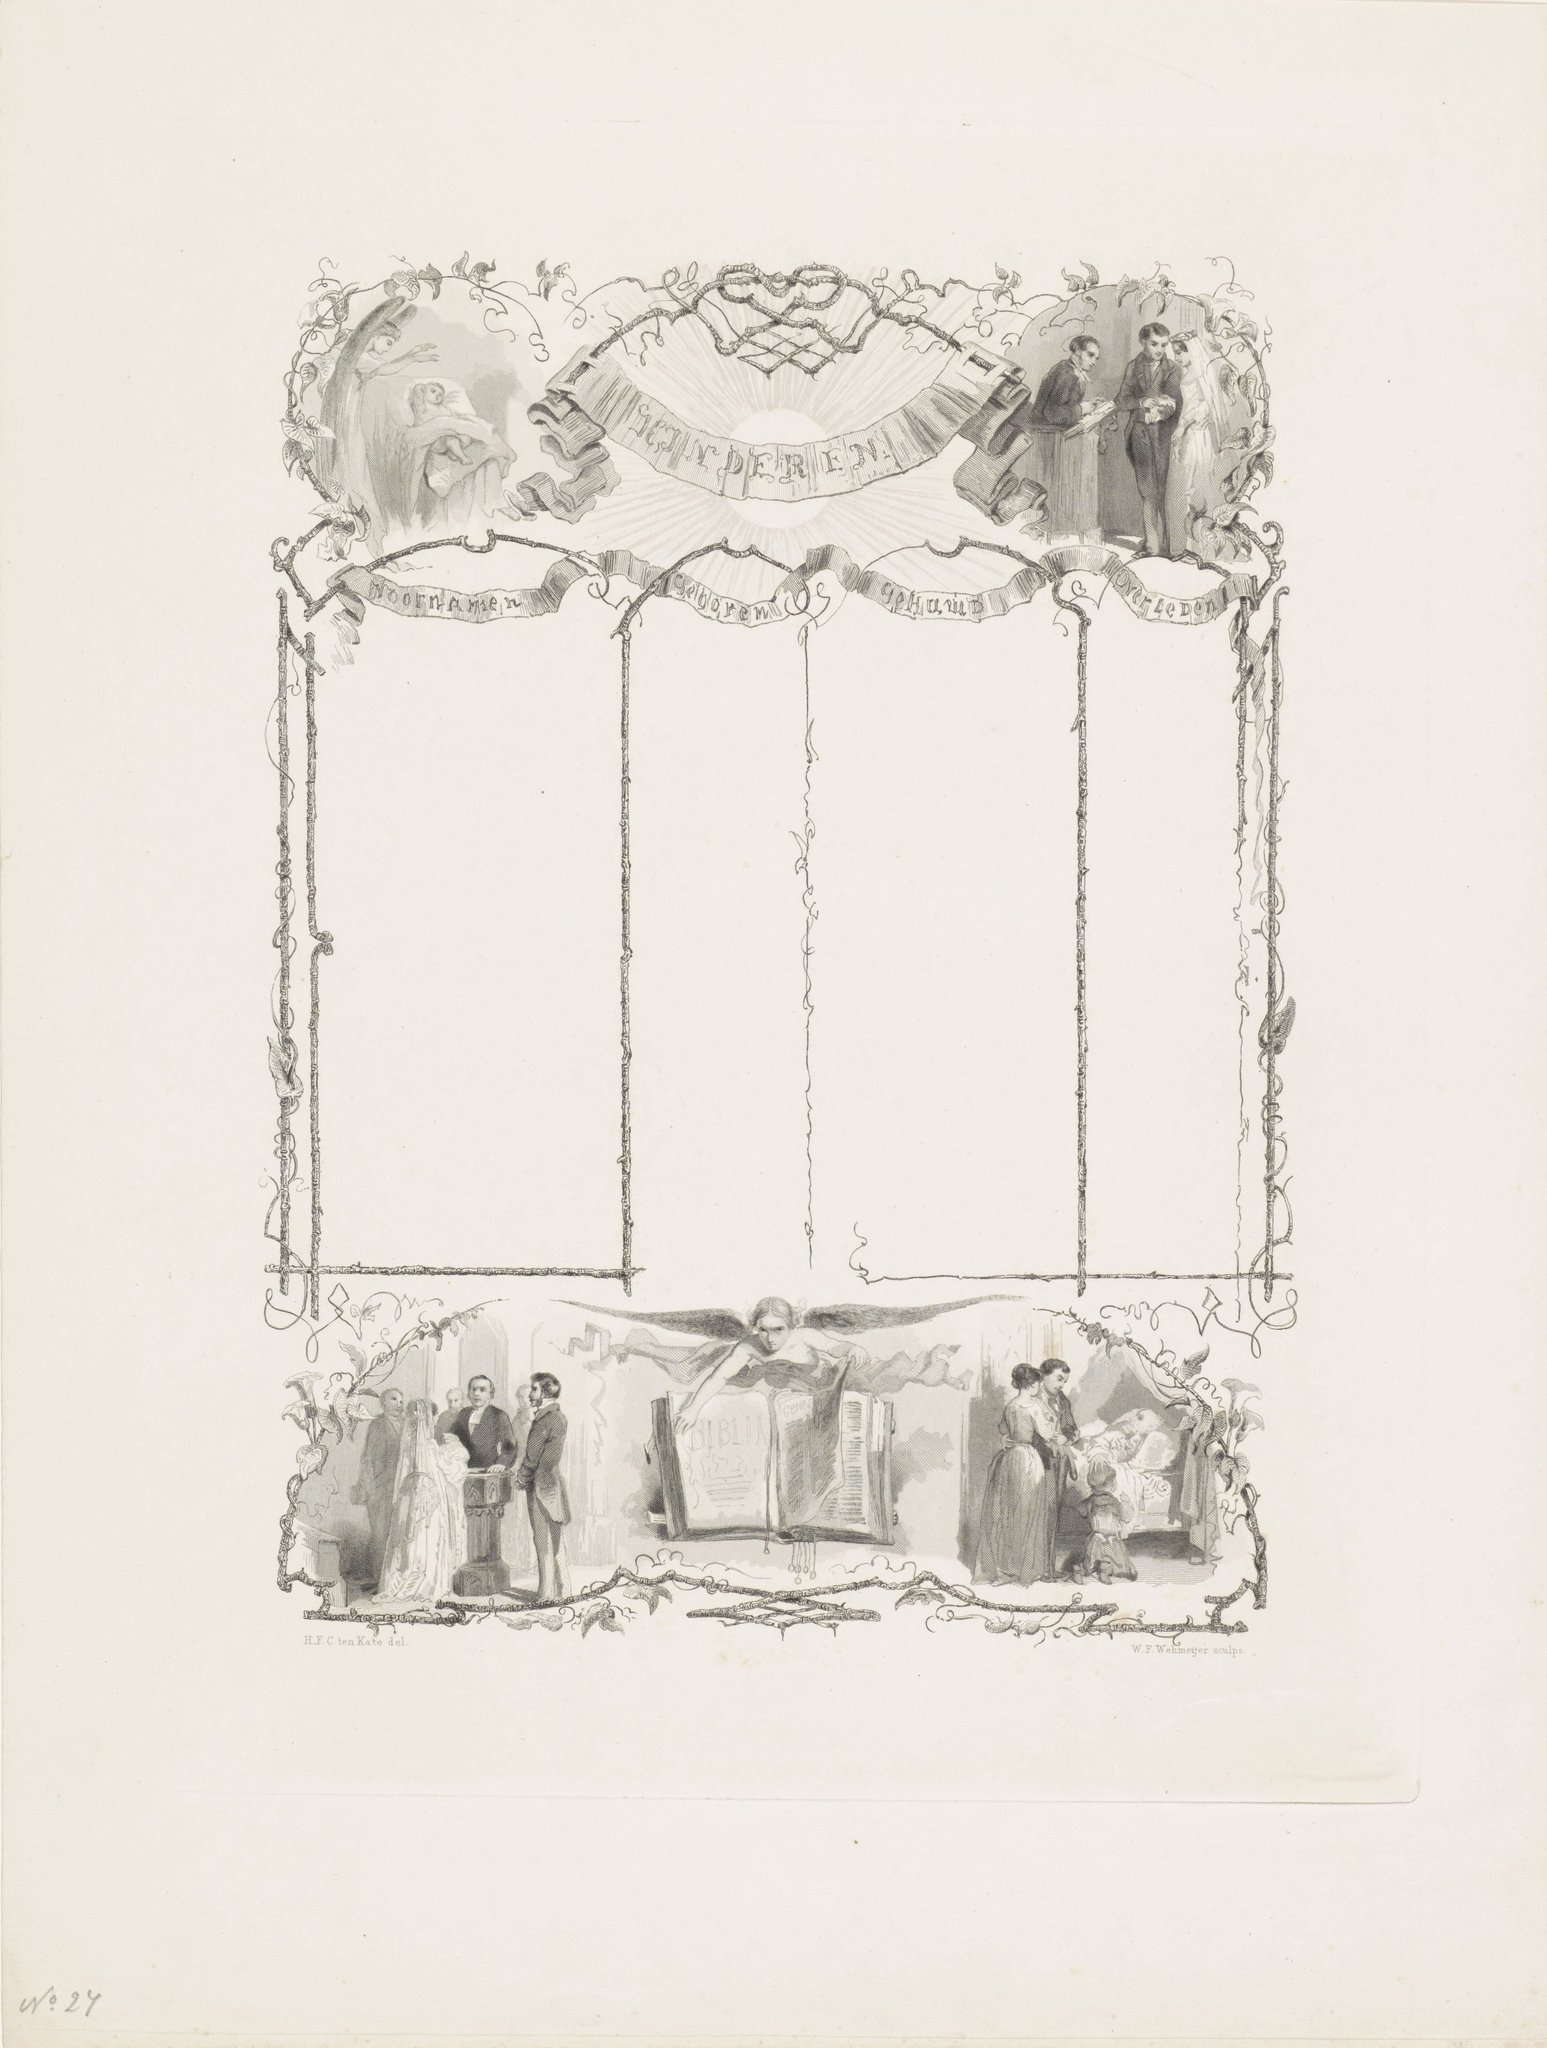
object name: print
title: Pagina voor een familieregister met familietaferelen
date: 1837-1854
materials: paper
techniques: etching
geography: amsterdam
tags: marriage in church ~ the sixth of the seven sacraments, deathbed, family, descendance, confinement, birth, baptism, christening ceremony ~ the first of the seven sacraments - qq - baptism in the open air, angels, the bible as a book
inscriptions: collector's mark: Lugt 2228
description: Pagina voor de gegevens van de kinderen. In het midden vier kolommen voor de namen, geboortedata, trouwdata en overlijdensdata. Boven een banderol met de tekst 'Kinderen' tussen een voorstelling van een engel aan het bed van een baby links en een huwelijk rechts. Onder in het midden een engel die boven een opengeslagen Bijbel zweeft met links een voorstelling van de doop en rechts een paar en een kind aan het sterfbed van een oude man.